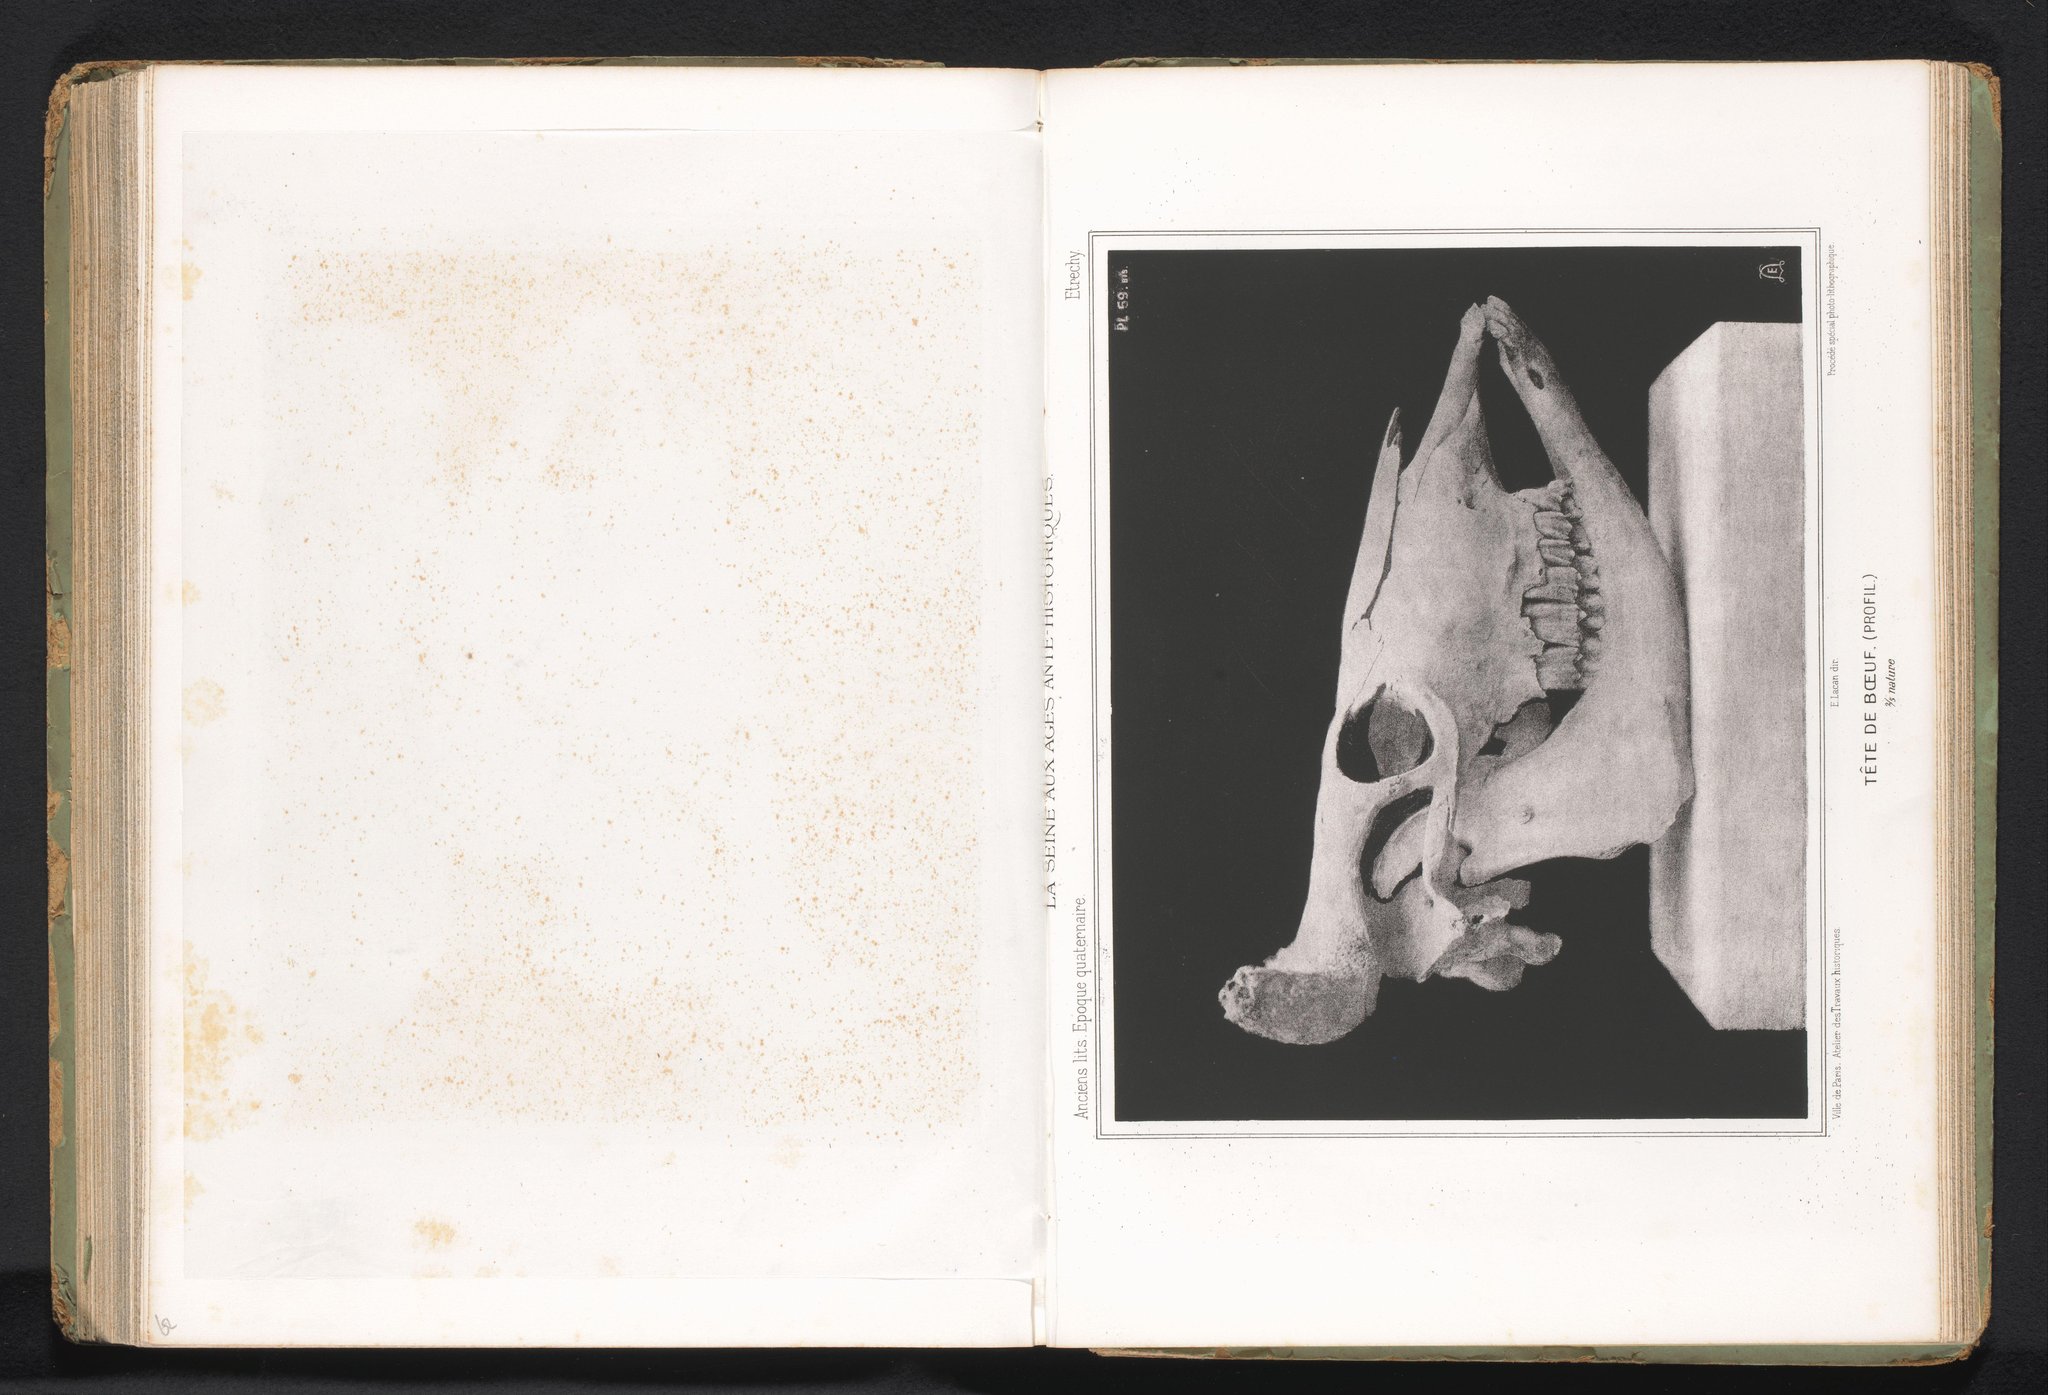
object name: page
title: Kop van een rund, en profil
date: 1864-1869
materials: paper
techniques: photolithography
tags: mammals (+ skeleton of an animal)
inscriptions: inscription: ‘2/5 nature’, monogram: ‘EL’, inscription: ‘Procédé spécial photo-lithographique’, inscription: ‘PL. 59 bis’